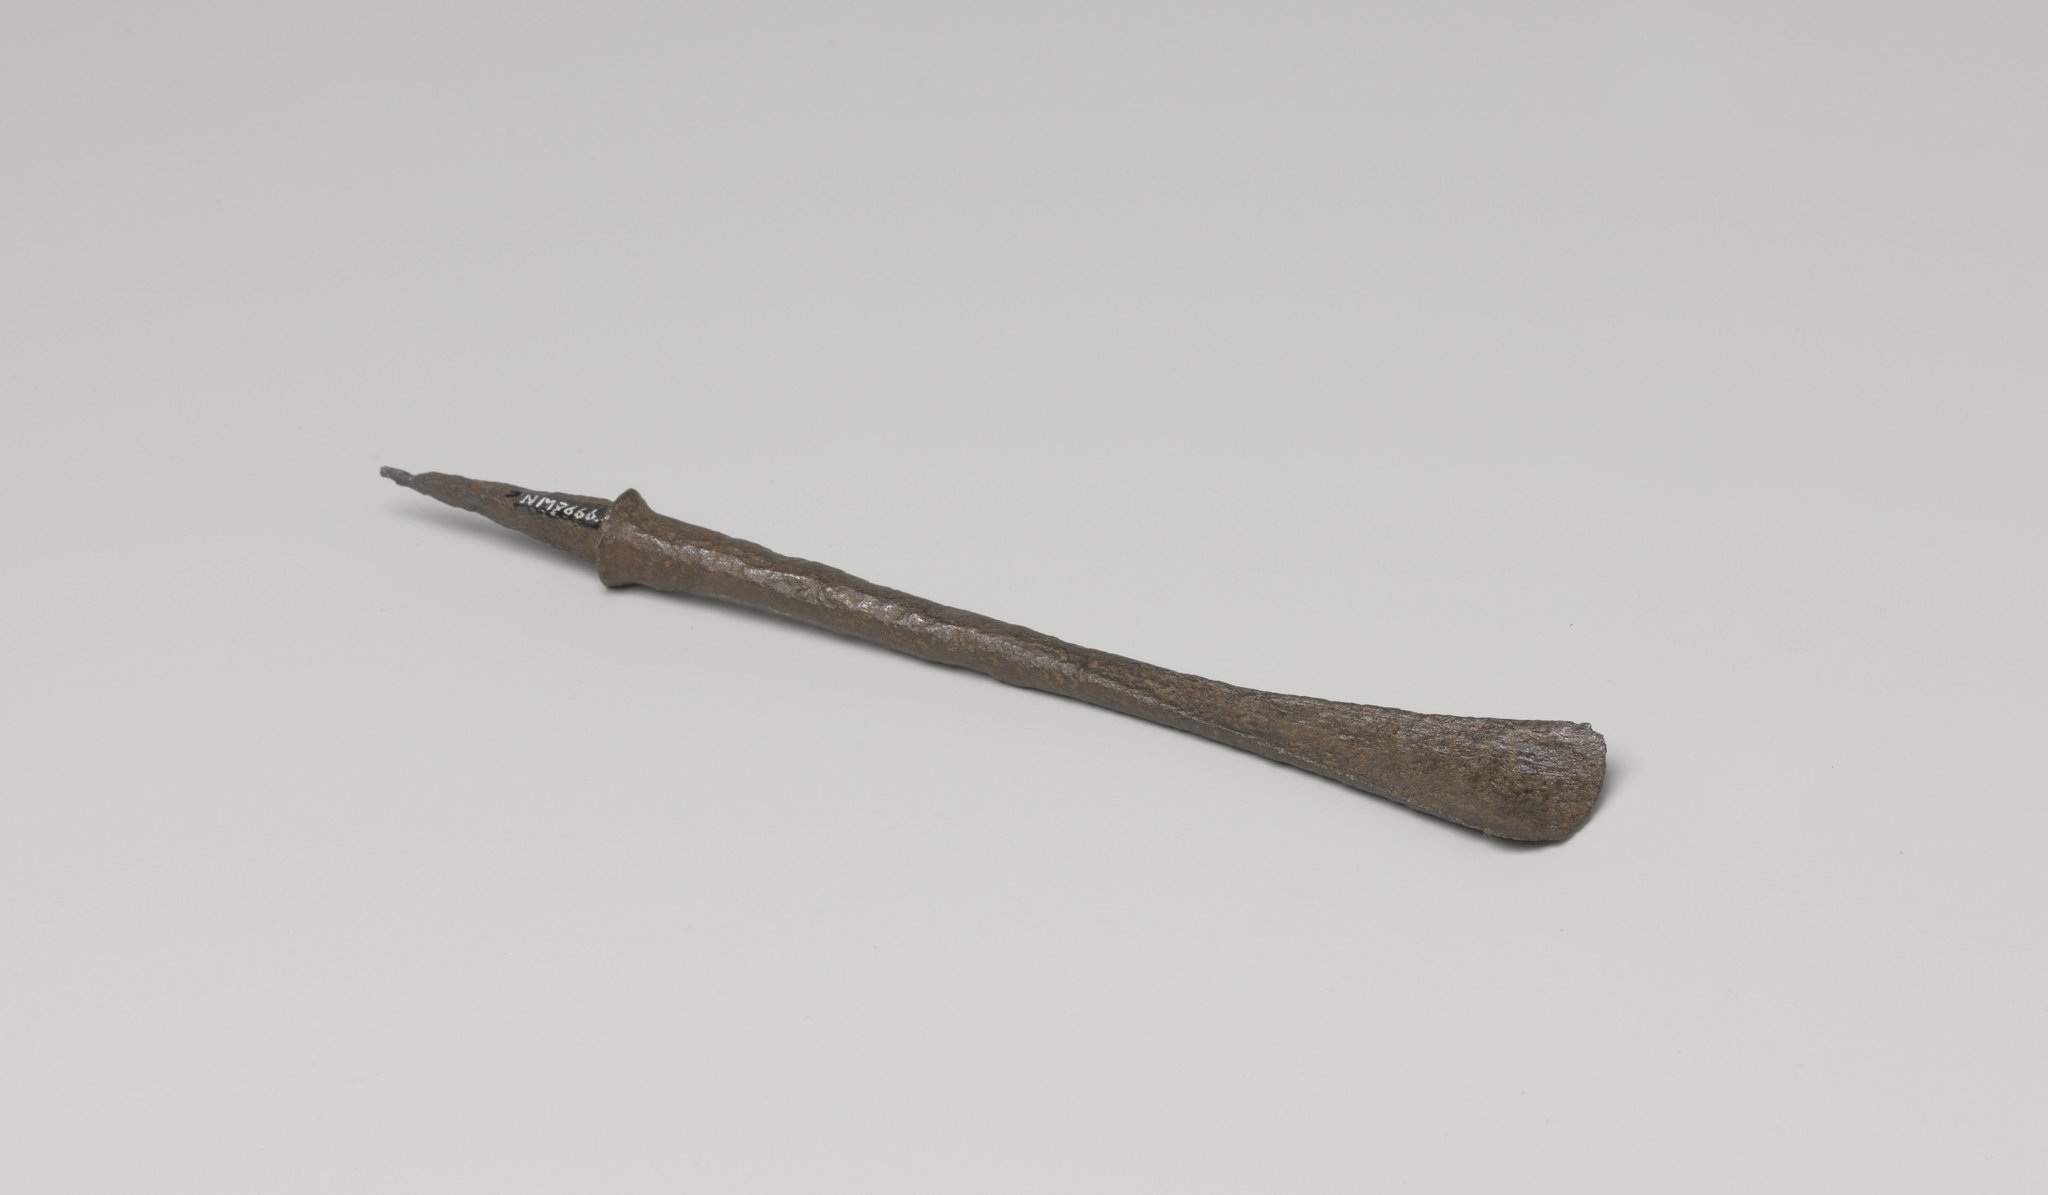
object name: chisel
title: Guts of holle beitel met schuin uitlopende snede en een beitel met randlijst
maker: Anonymous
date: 1590-1596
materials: iron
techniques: forging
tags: willem barendsz., amsterdam, jacob van heemskerck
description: Gouges or hollow chisels